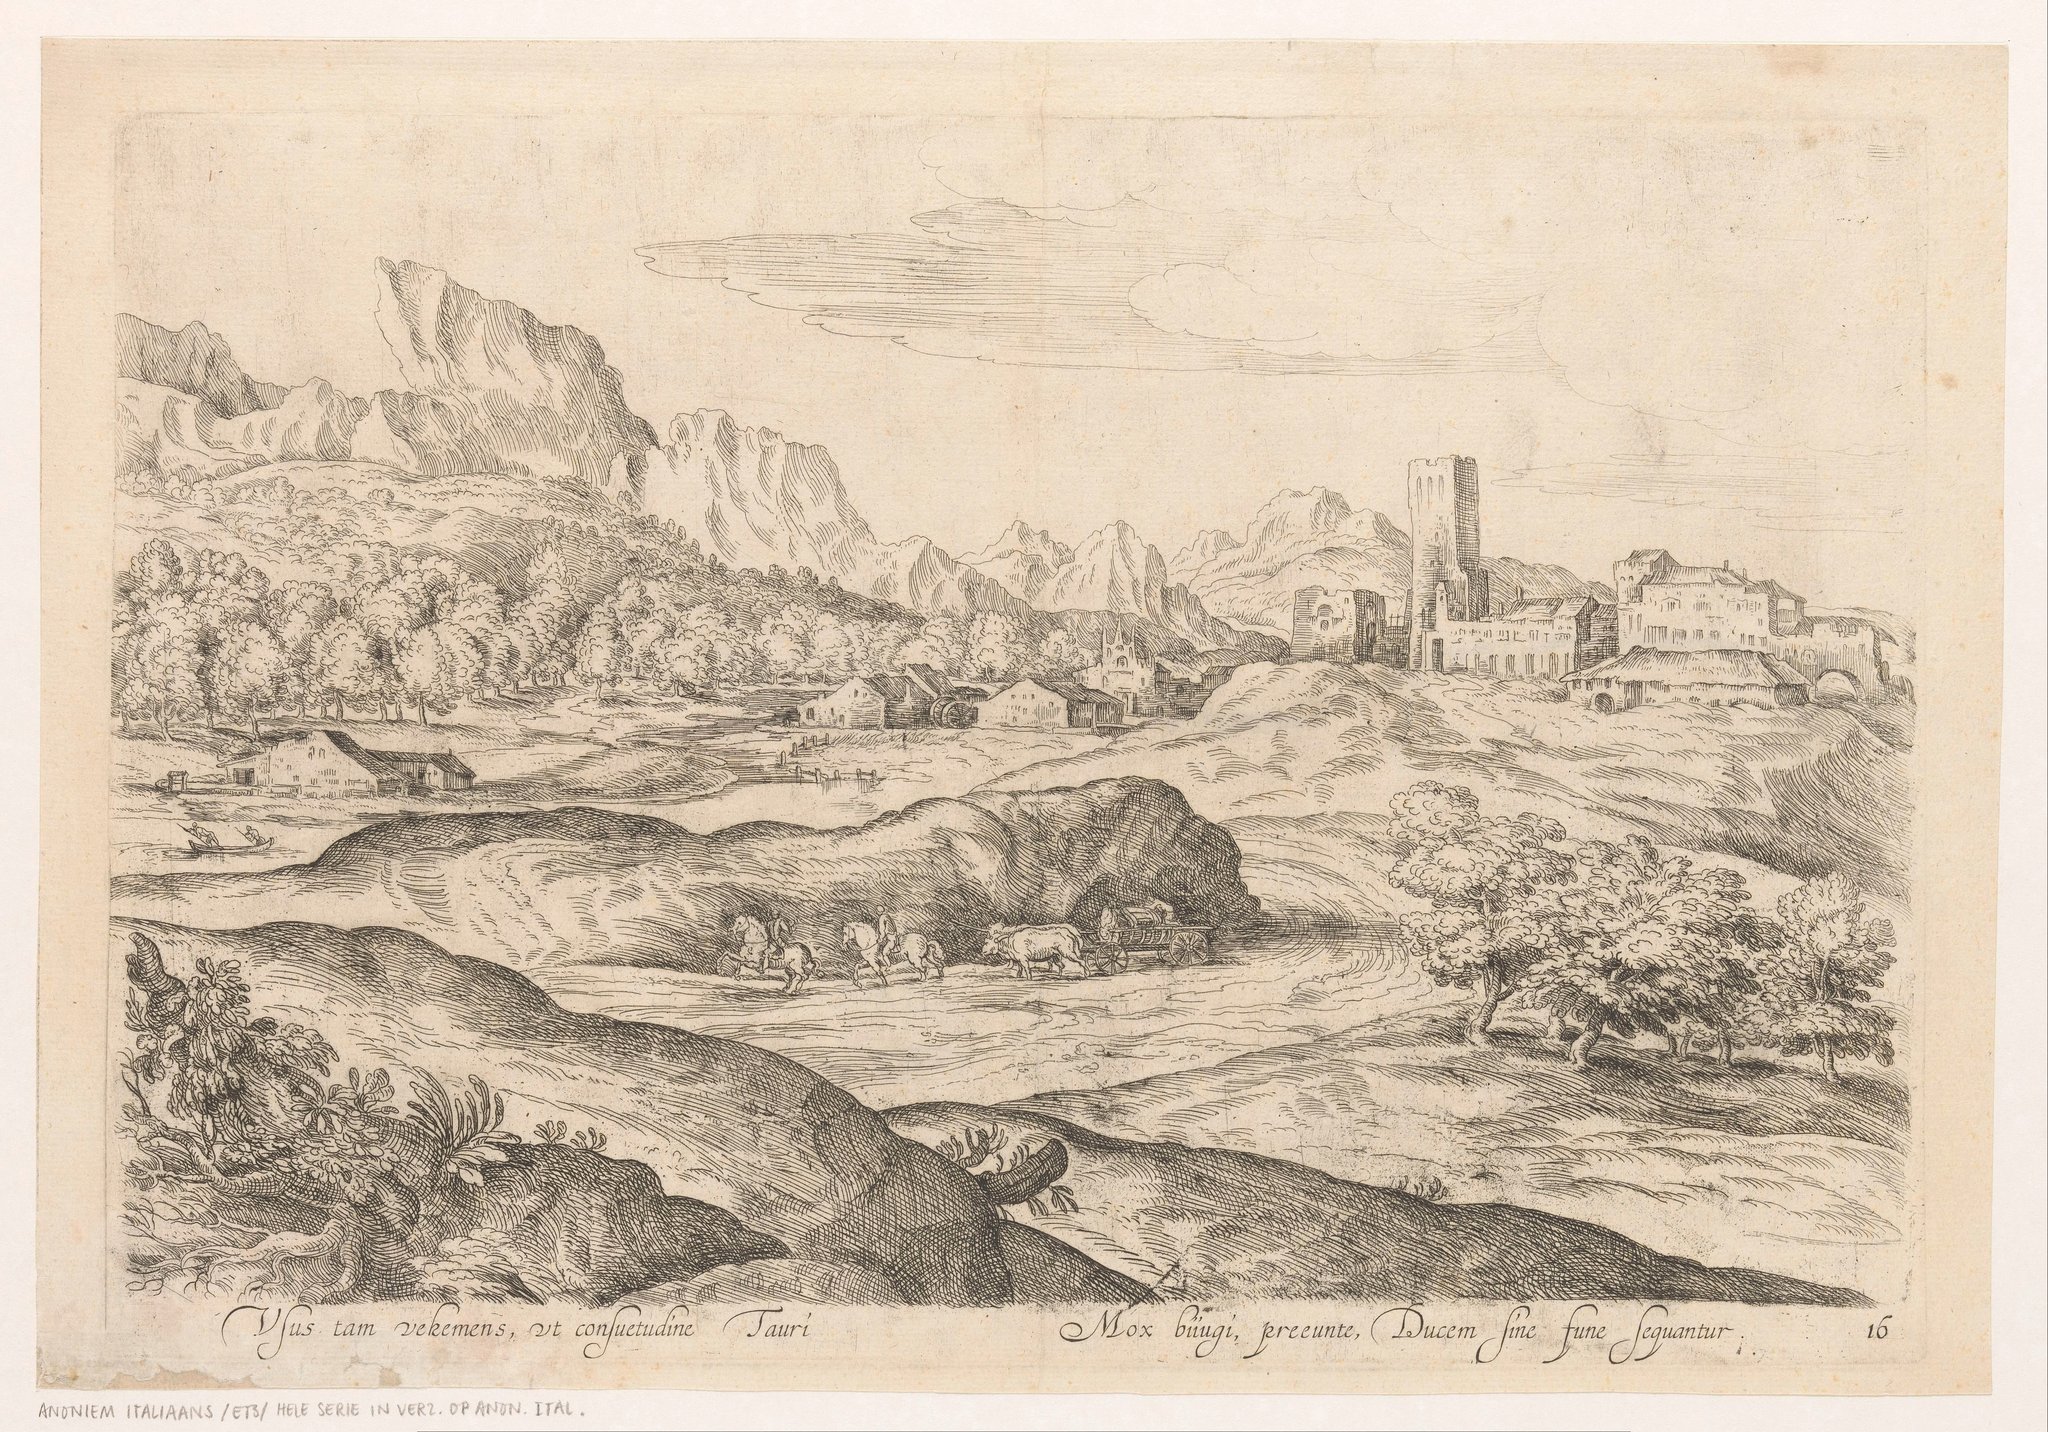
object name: print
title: Landschappen naar Domenico Campagnola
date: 1600-1699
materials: paper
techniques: etching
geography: italy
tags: riding a horse, ass, or mule; rider, horseman, landscapes, ox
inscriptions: collector's mark: Lugt 2228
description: Een landschap met een nederzetting. Op de voorgrond rijden twee mannen te paard en achter hen trekken twee ossen een kar. Titel in het Latijn in ondermarge. Genummerd rechtsonder: 16.